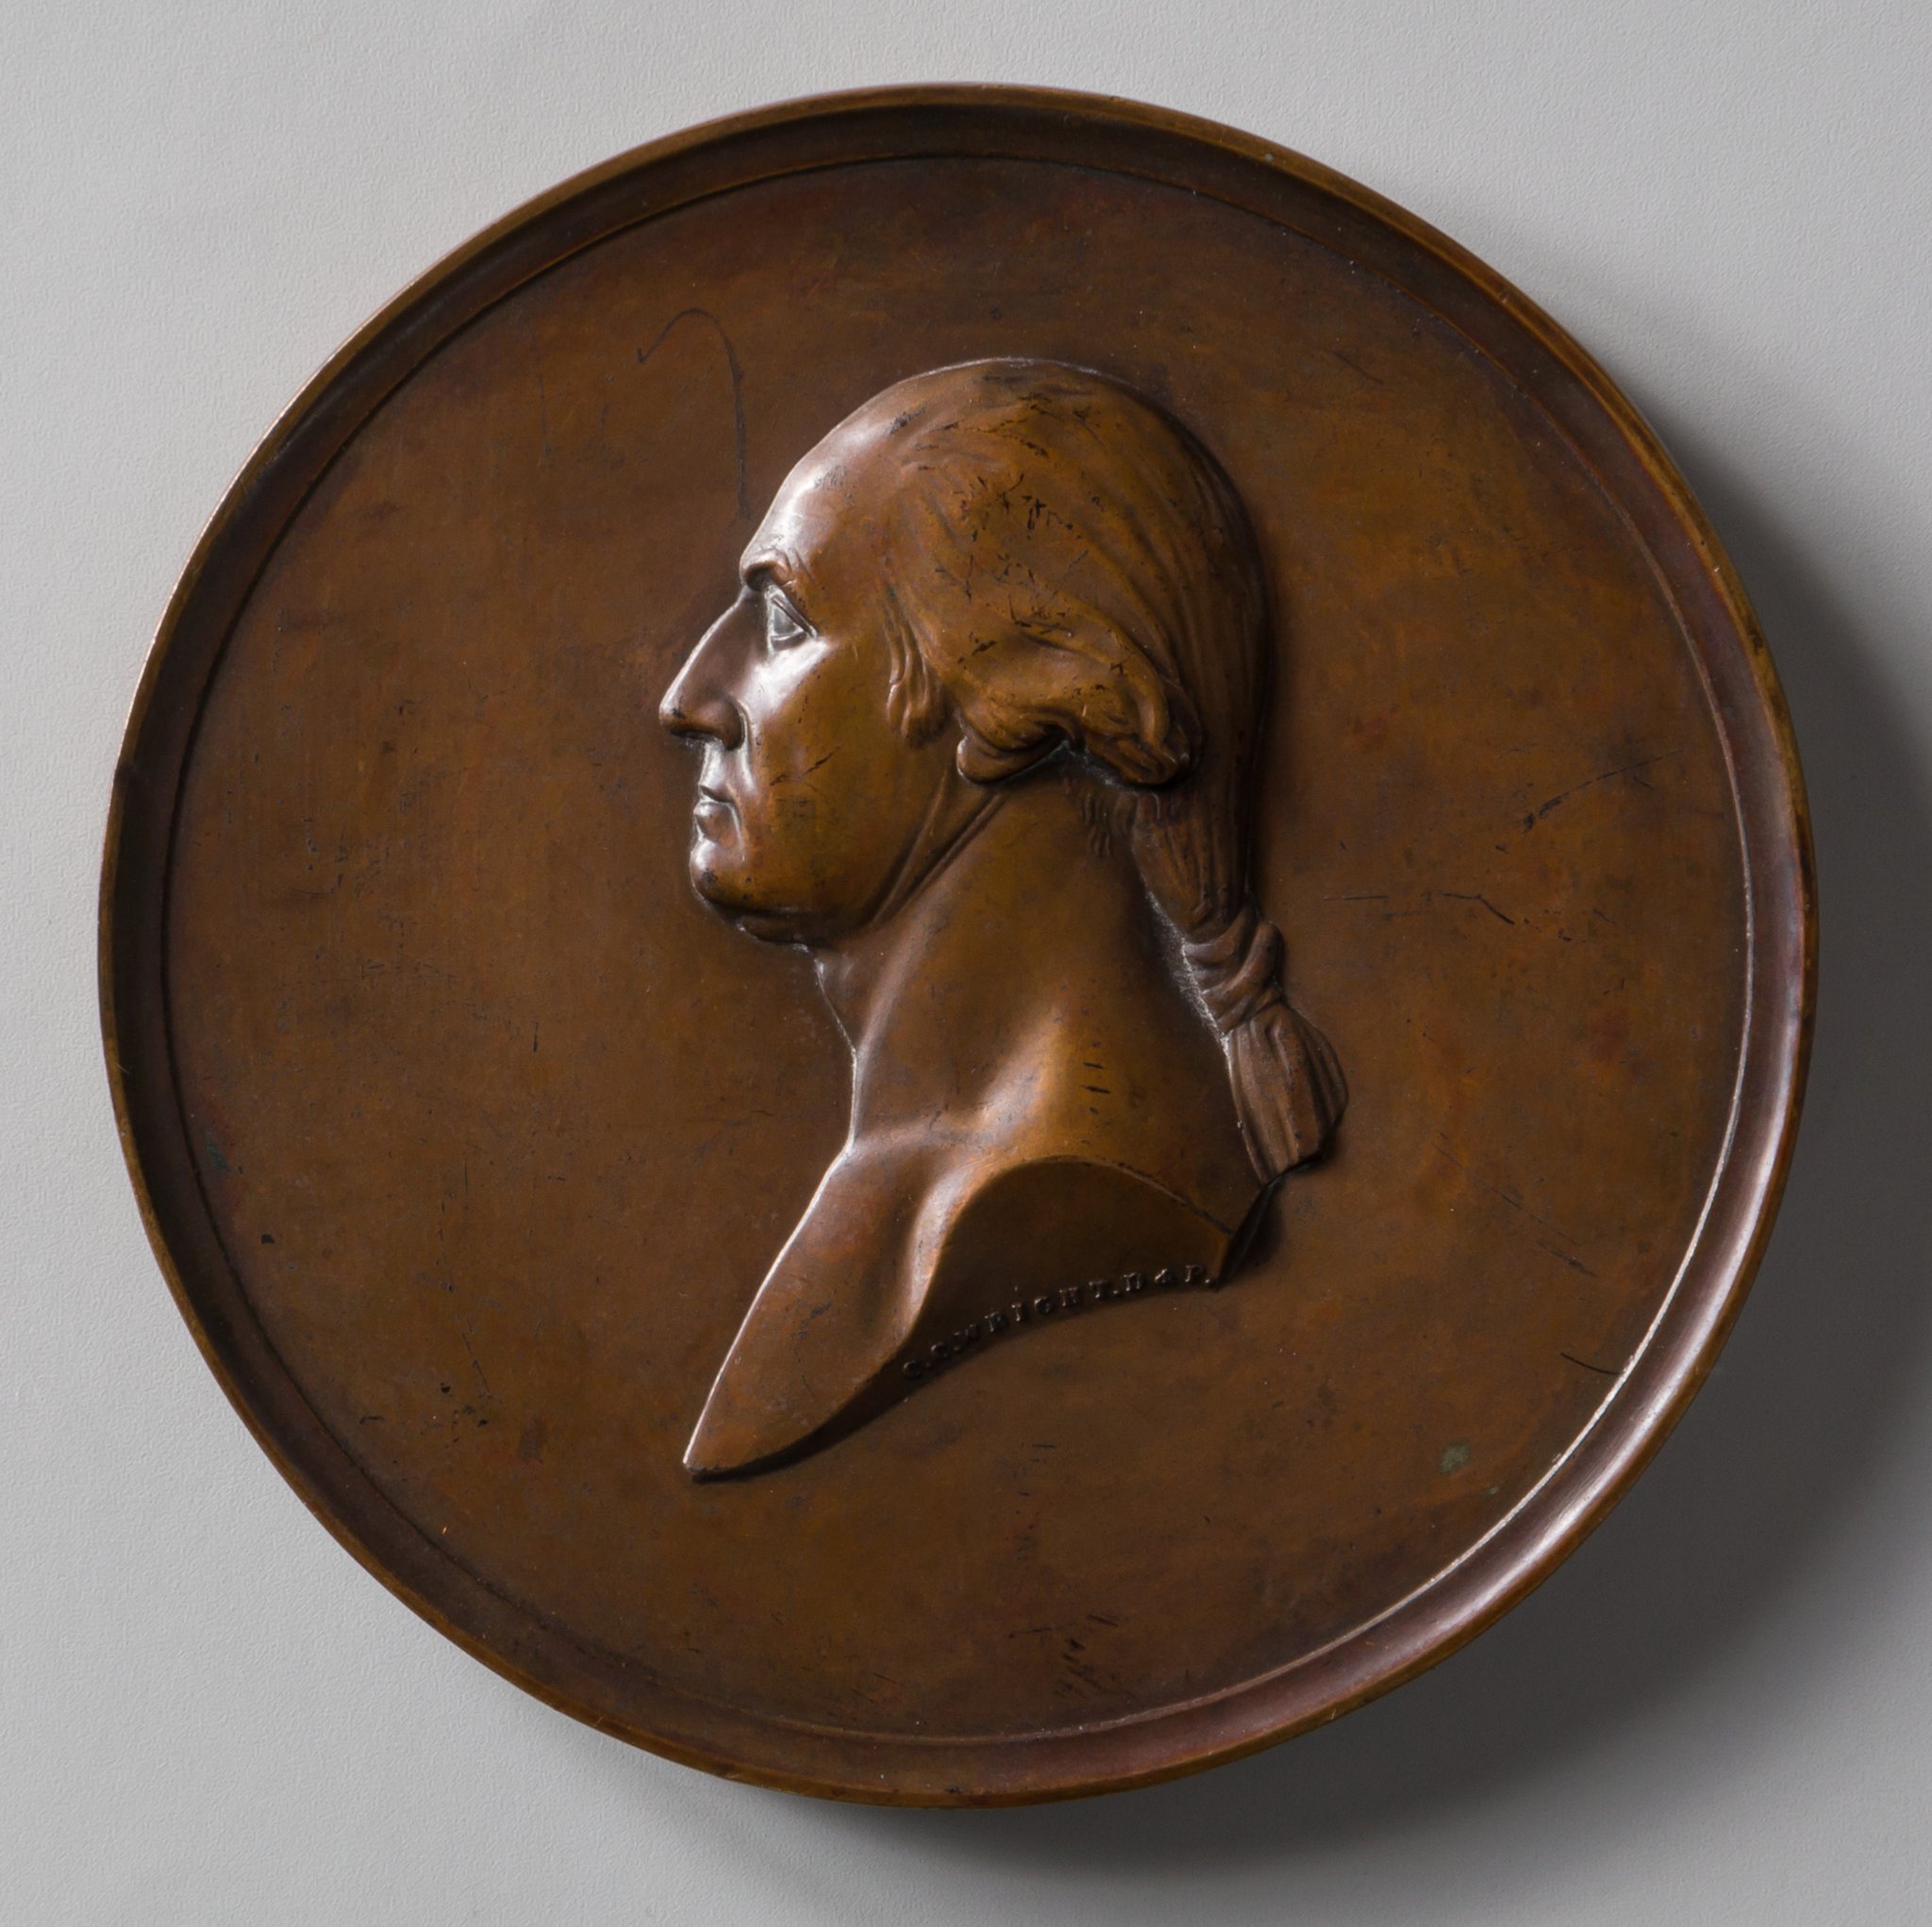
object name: medal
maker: charles cushing wright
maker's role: maker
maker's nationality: american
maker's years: 1796-1854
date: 1818-1854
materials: bronze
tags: george washington,men,profiles